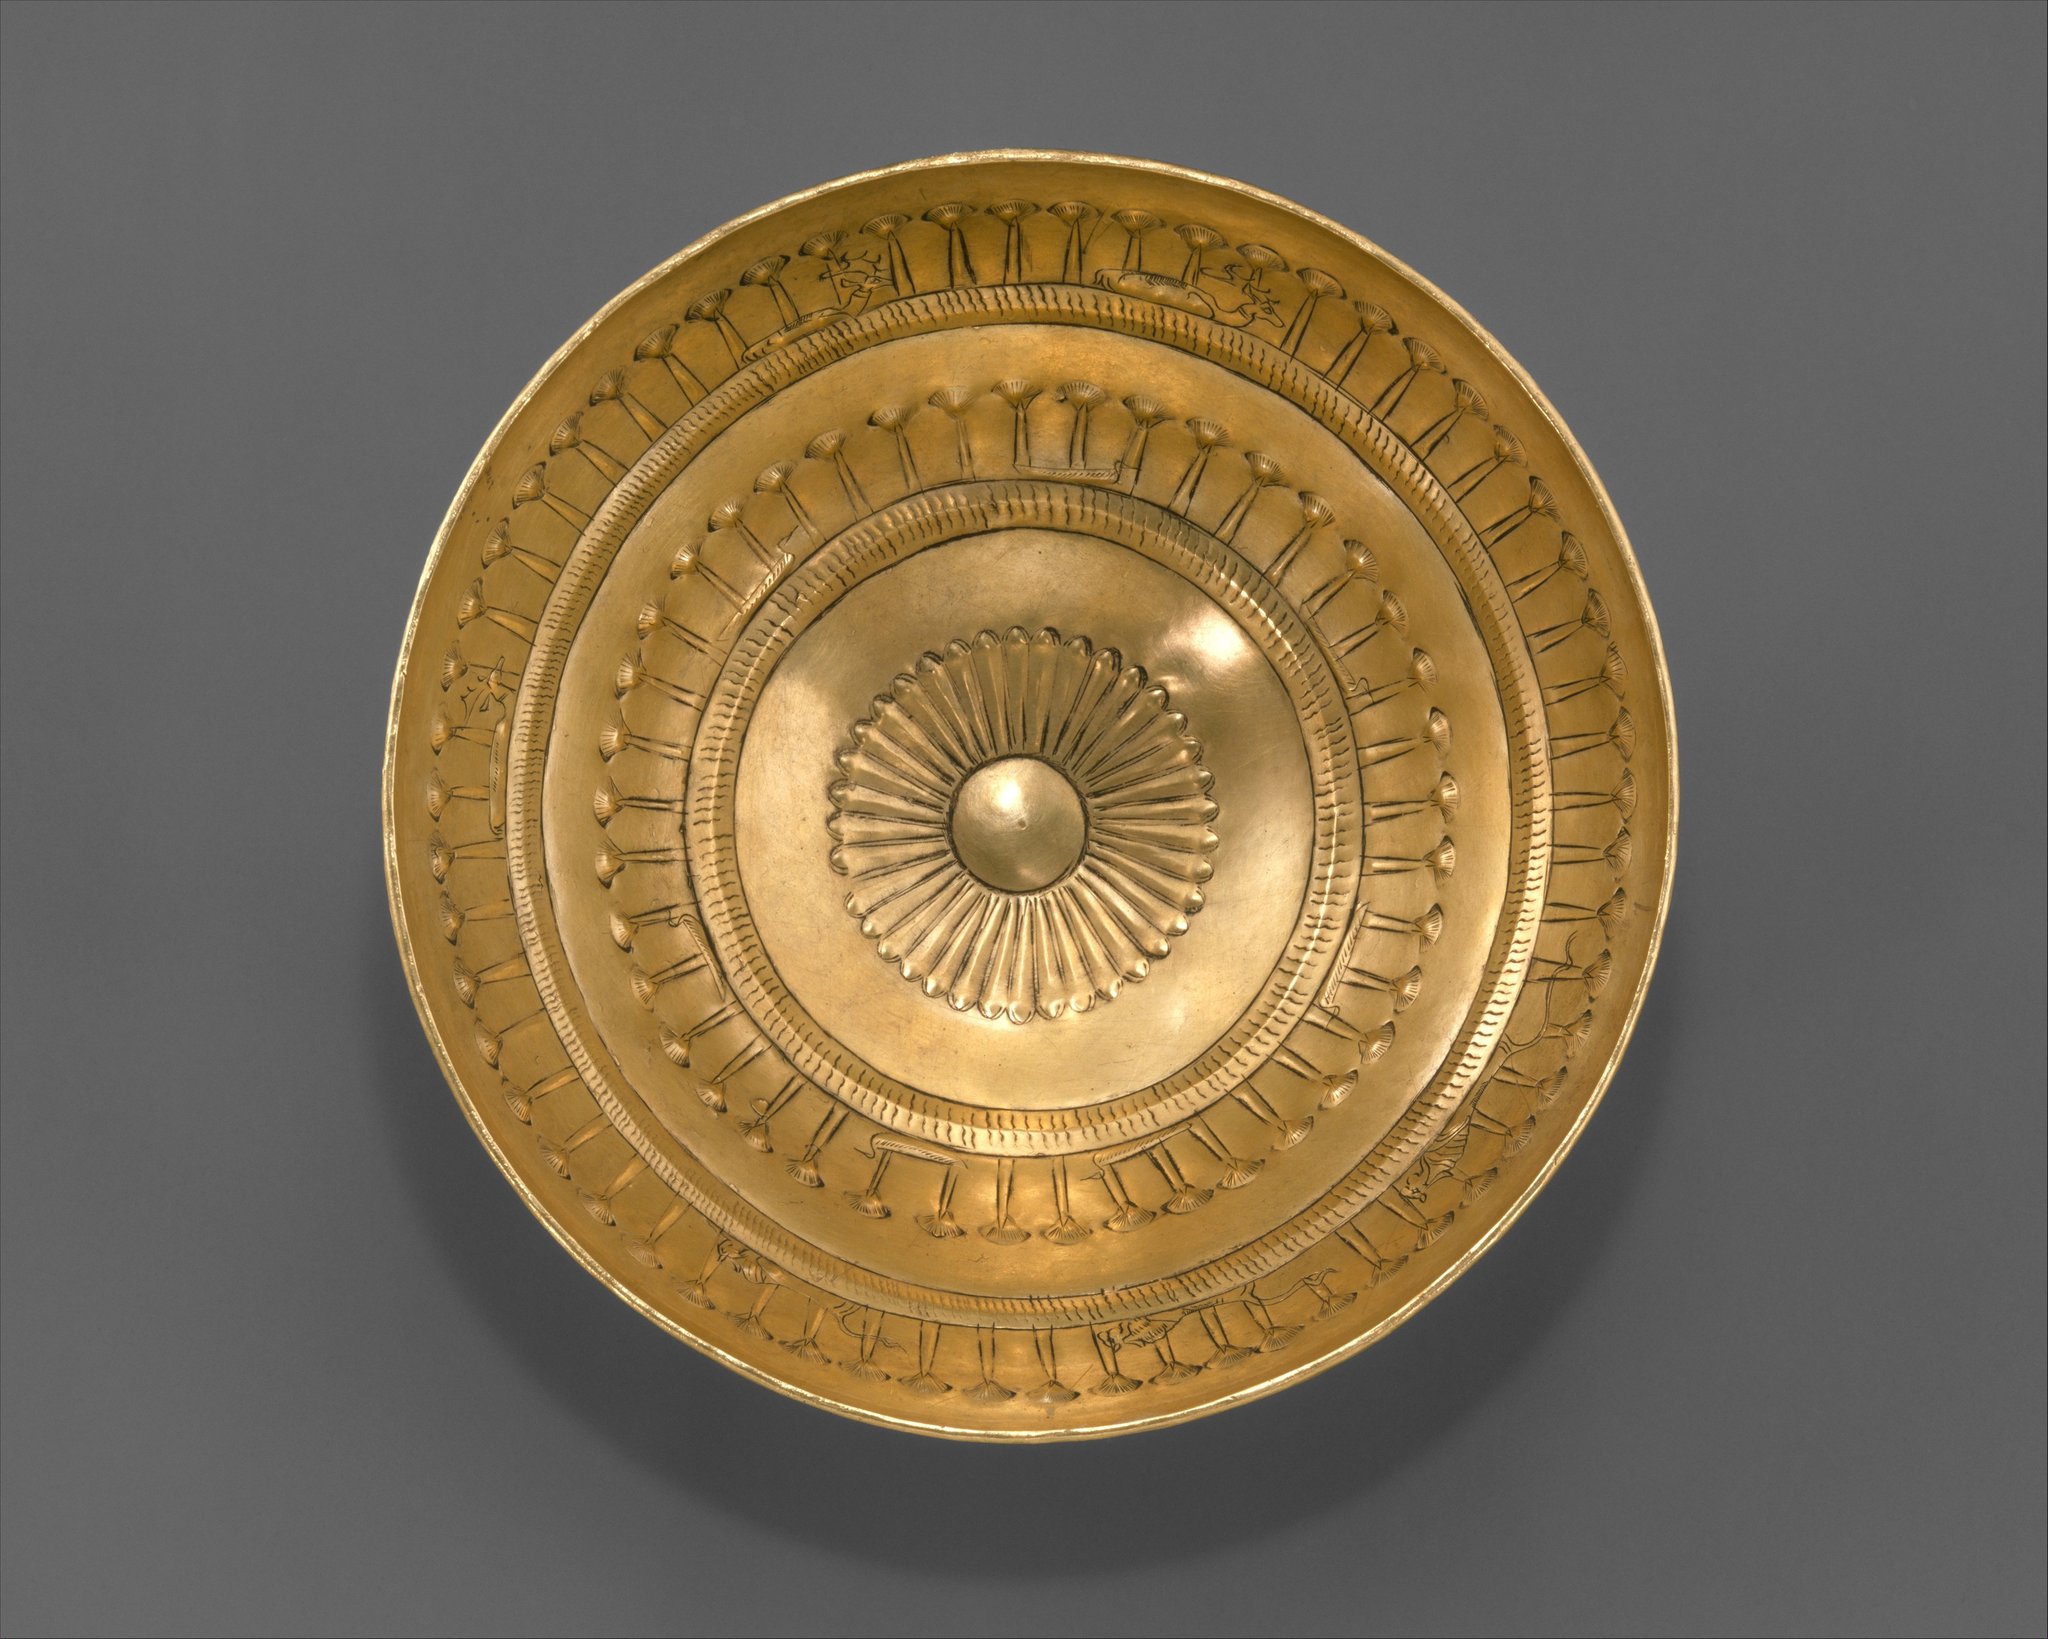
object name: bowl with rosette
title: Gold bowl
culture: cypriot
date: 700 BCE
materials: gold